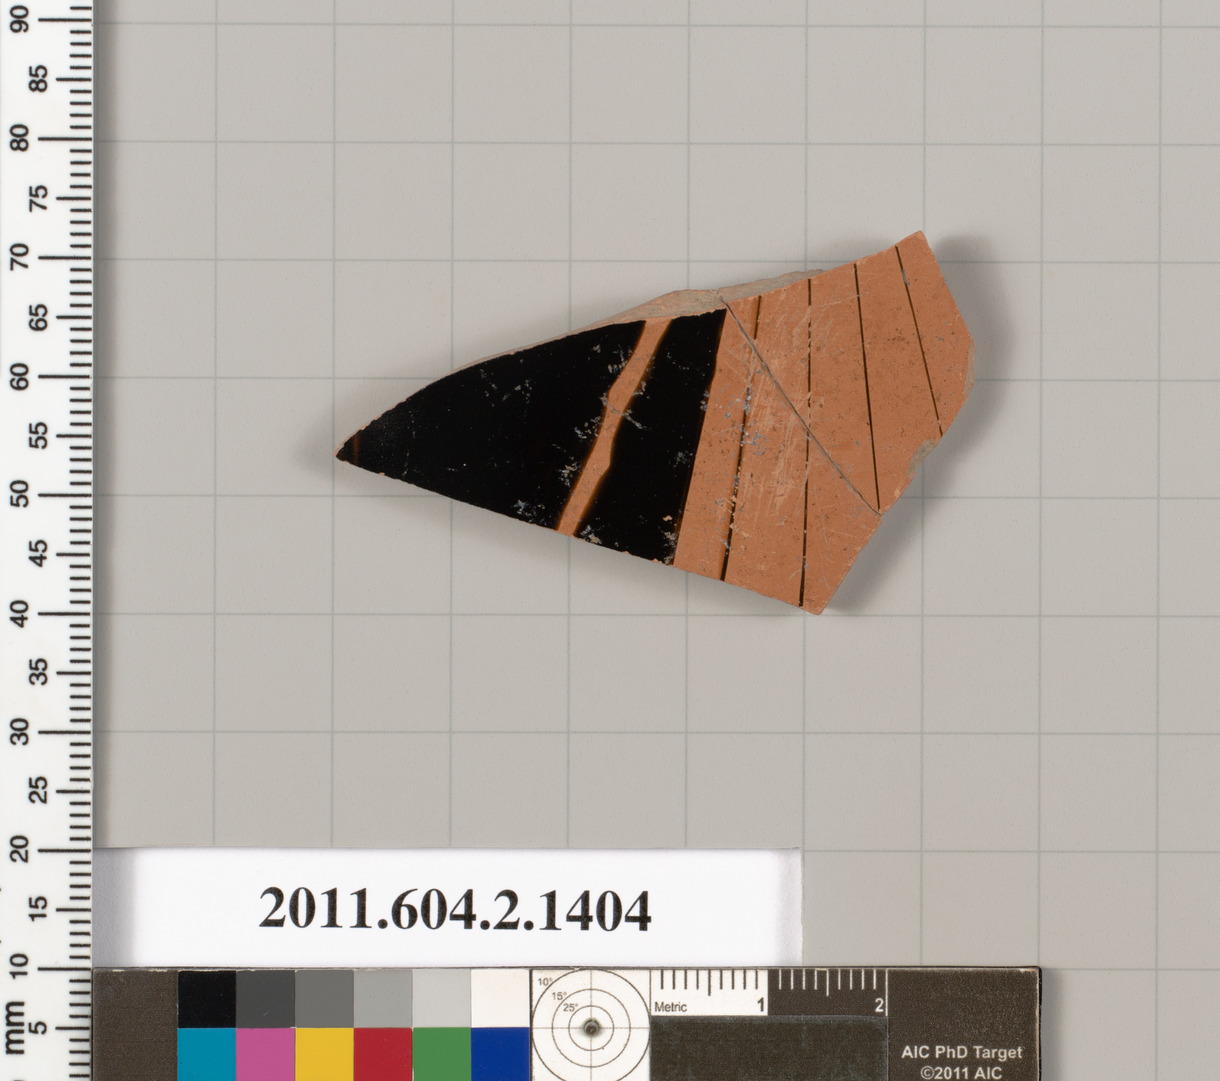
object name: skyphos fragment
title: Terracotta fragment of a skyphos (deep drinking cup)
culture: greek, attic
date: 475-451 BCE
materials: terracotta